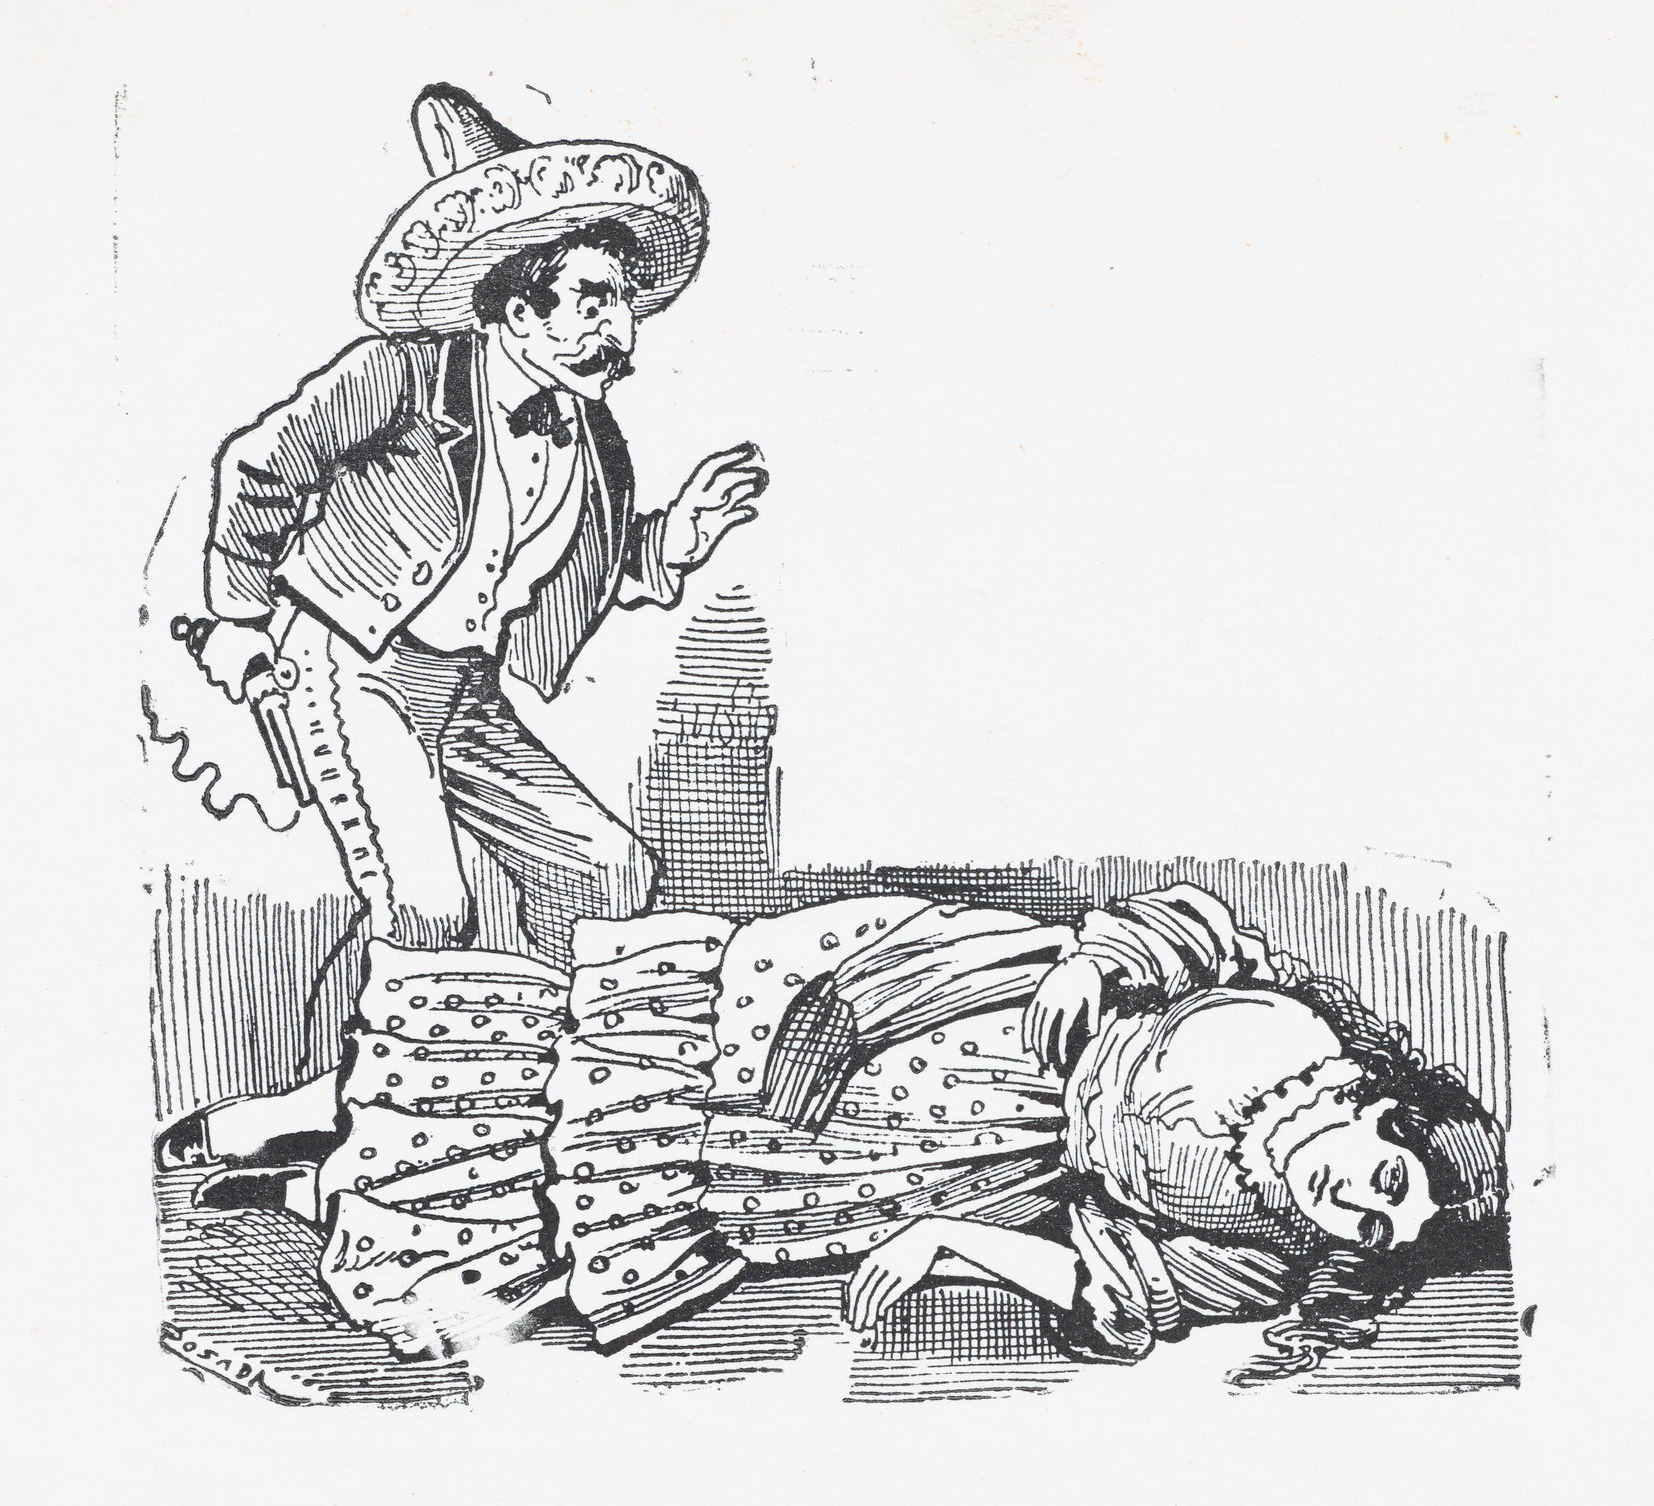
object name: print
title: A man with a gun standing over a woman he has just shot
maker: josé guadalupe posada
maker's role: artist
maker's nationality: mexican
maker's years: 1852-1913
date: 1880-1910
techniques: lithography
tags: corpses,men,women